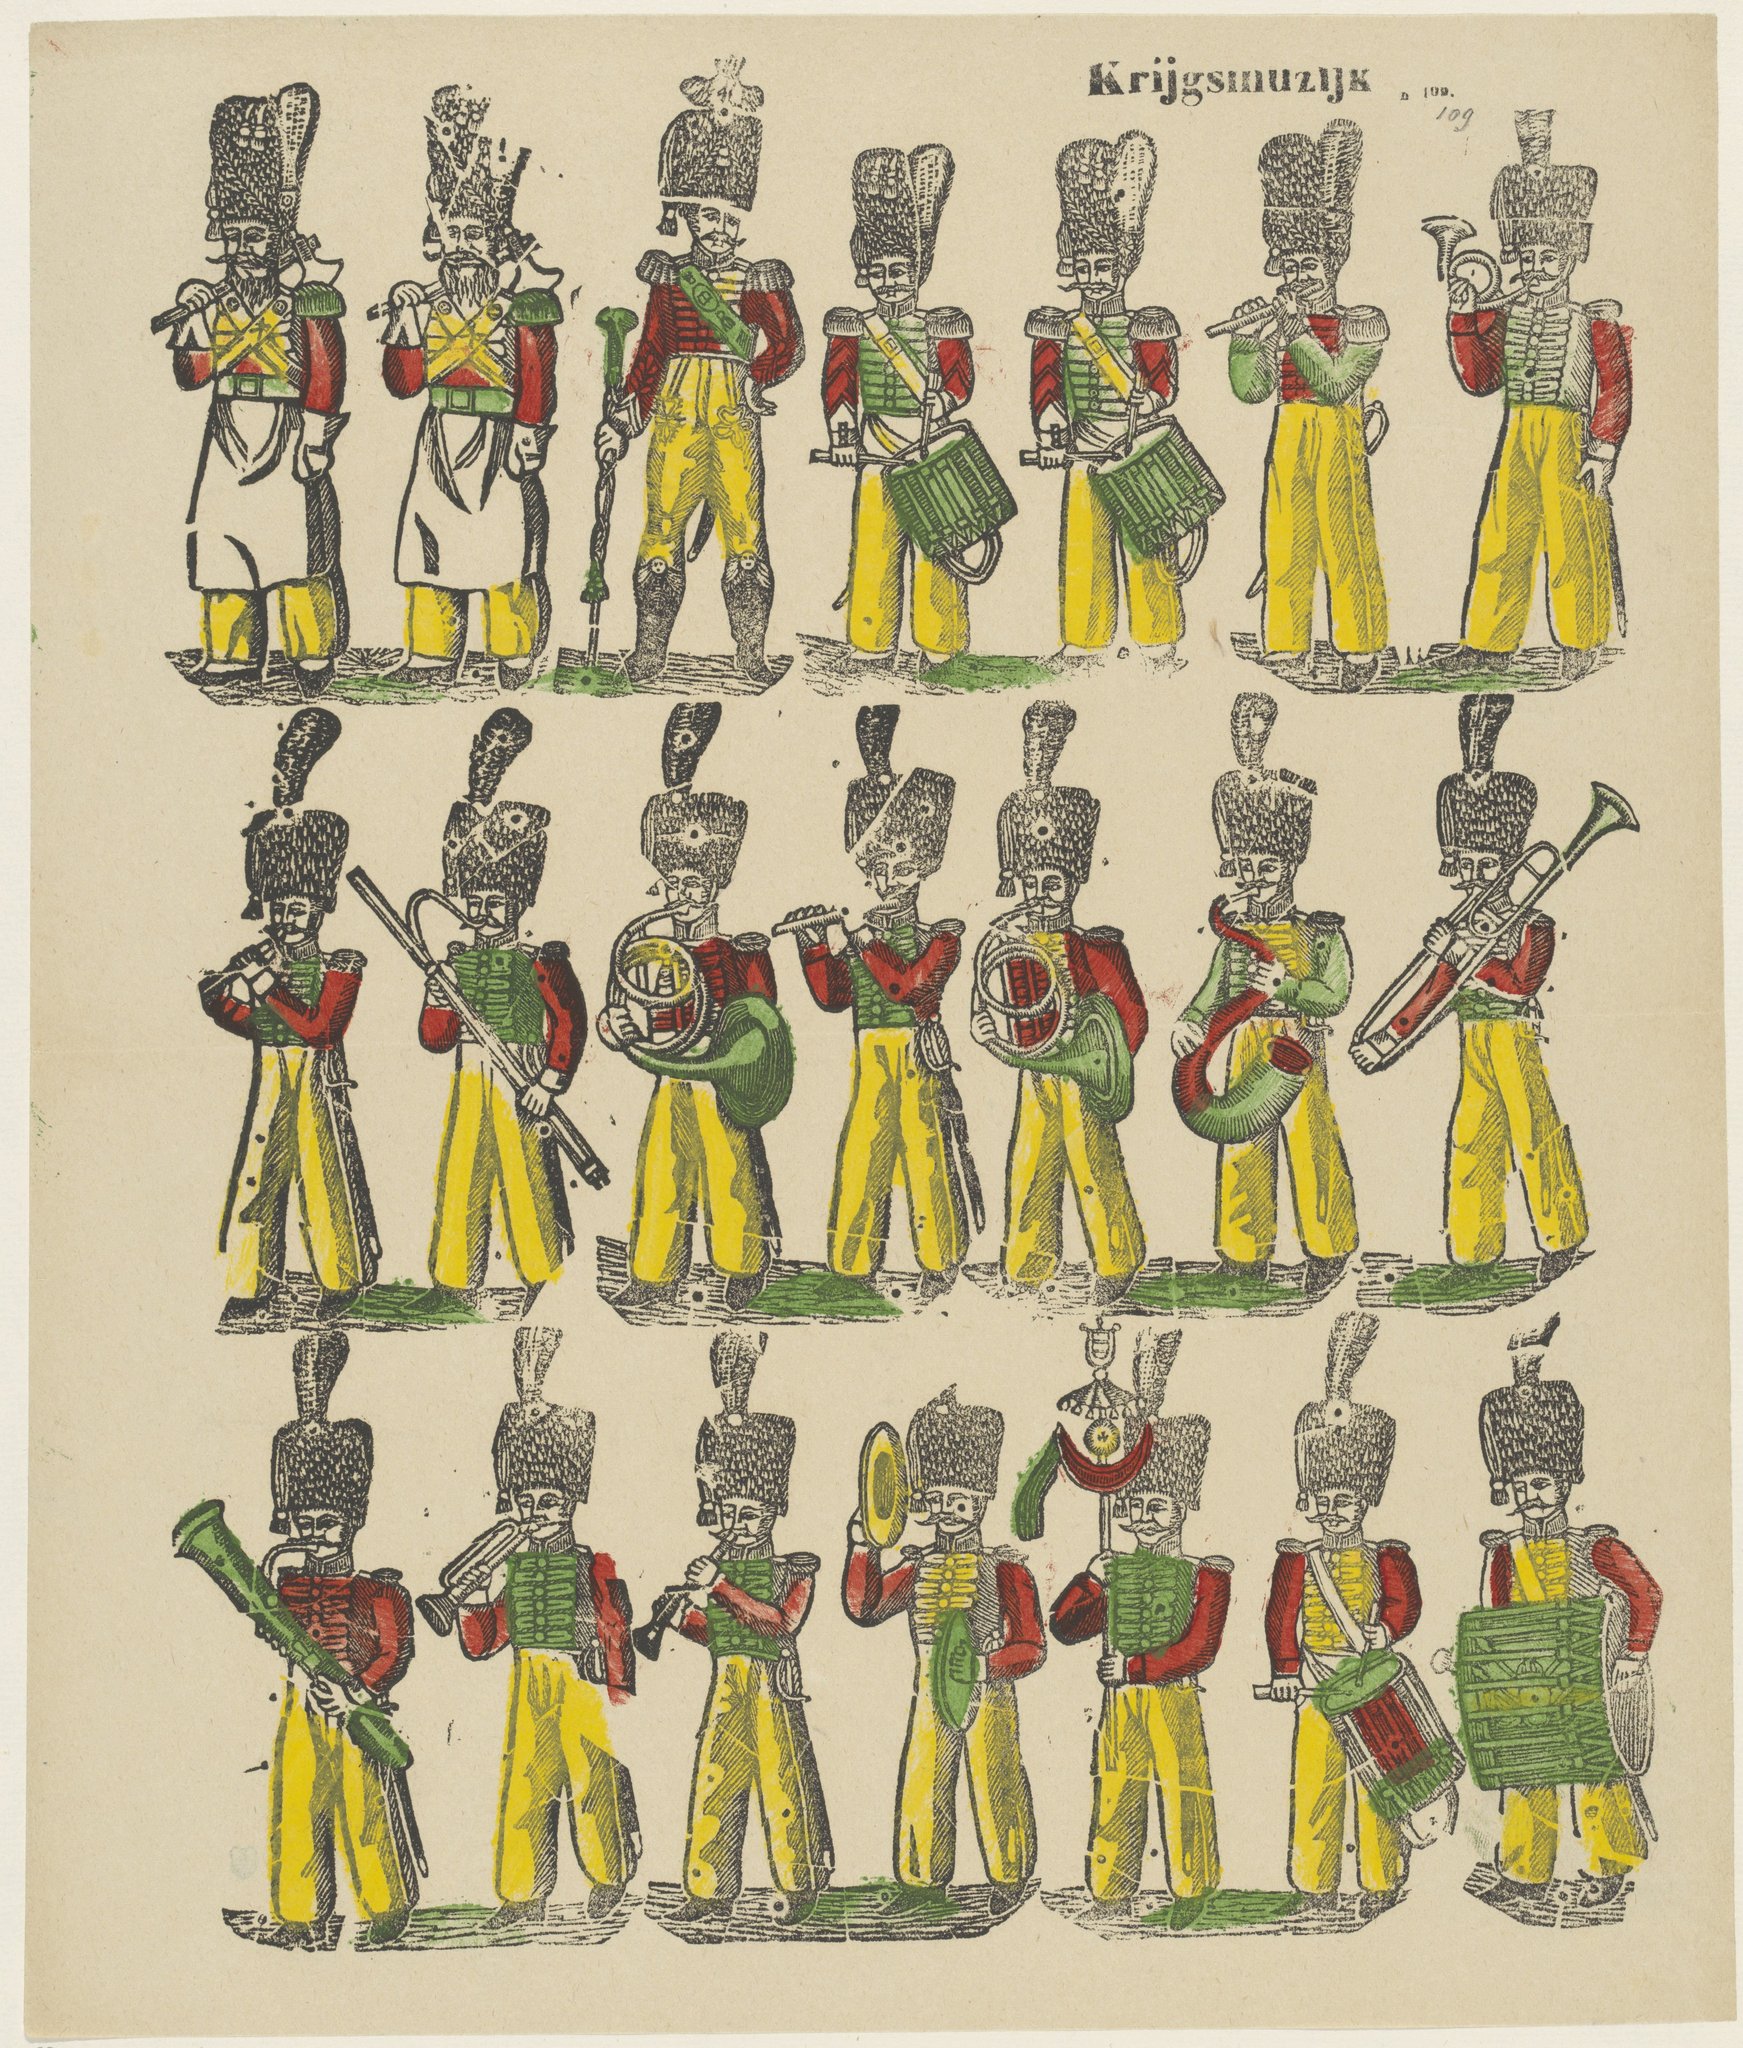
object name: print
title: Krijgsmuzijk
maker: Anonymous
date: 1856-1900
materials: paper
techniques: colour, letterpress printing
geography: turnhout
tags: military band, the soldier; the soldier's life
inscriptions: collector's mark: Lugt 2760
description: Blad met 3 horizontale rijen met elk 7 voorstellingen van militairen met muziekinstrumenten. Genummerd rechtsboven: n 109.